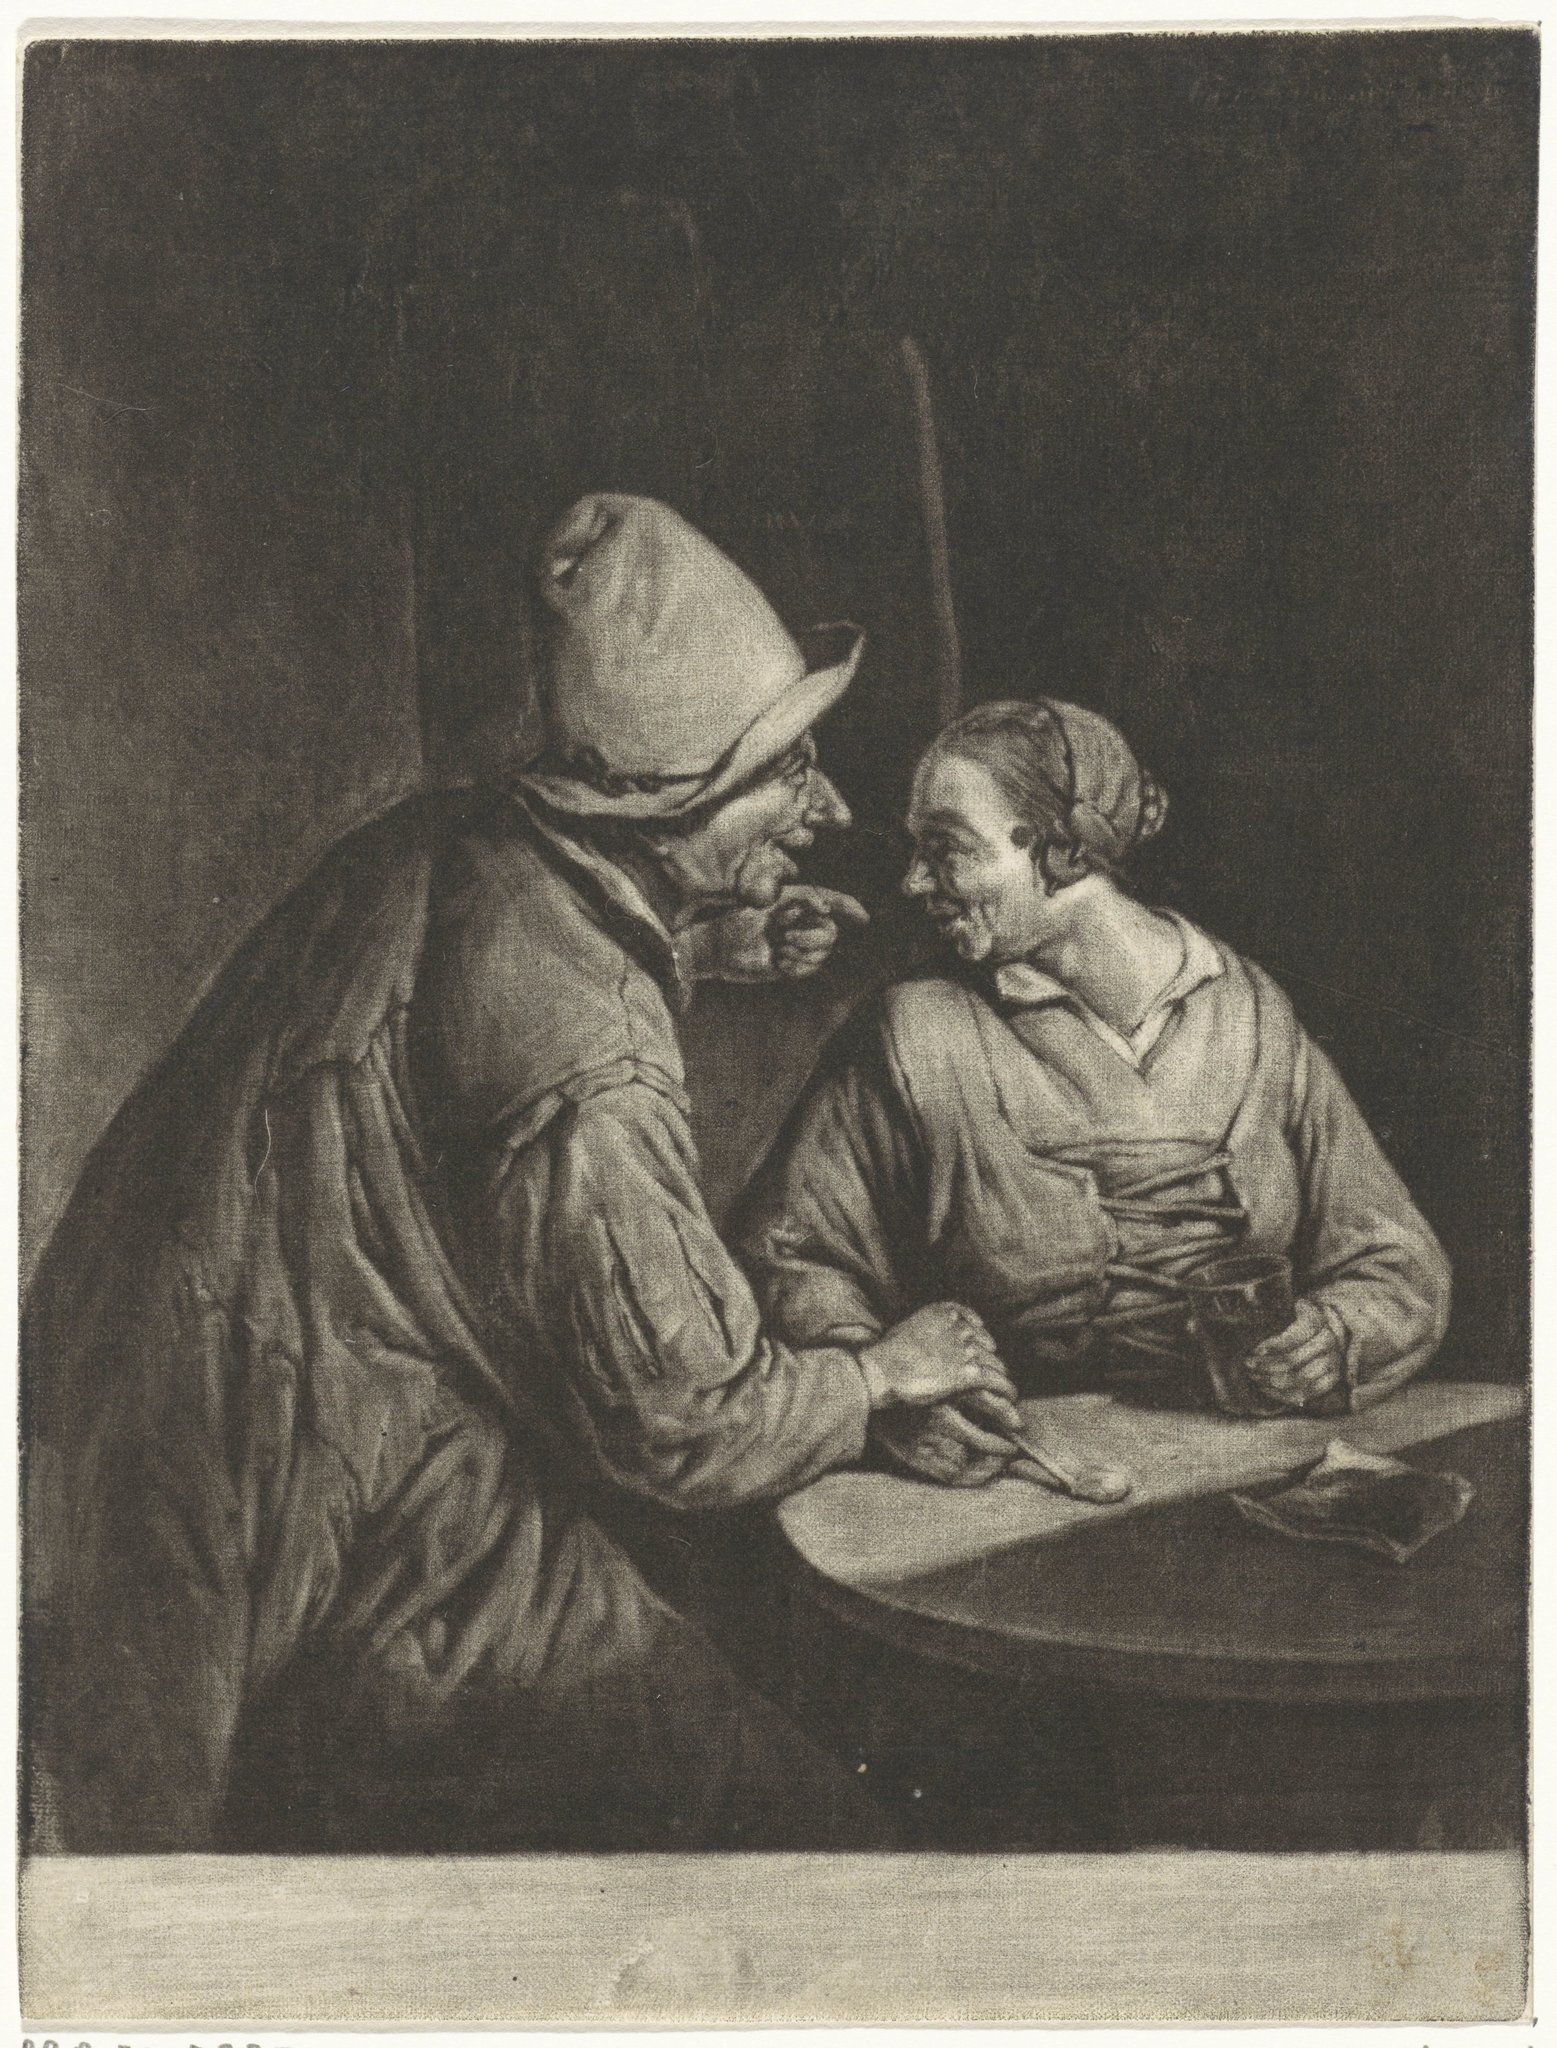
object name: print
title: Boer en boerin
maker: cornelis dusart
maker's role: draughtsman, painter, print maker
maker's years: 1660-1704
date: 1685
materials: paper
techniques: mezzotint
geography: haarlem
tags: pipe ~ tobacco, farmers - aa - female farmer, farmer's wife, glass of beer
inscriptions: collector's mark: Lugt 240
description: Een boer probeert een boerin het hof te maken met tabak en bier. Hij heeft zijn hand op de hare gelegd.